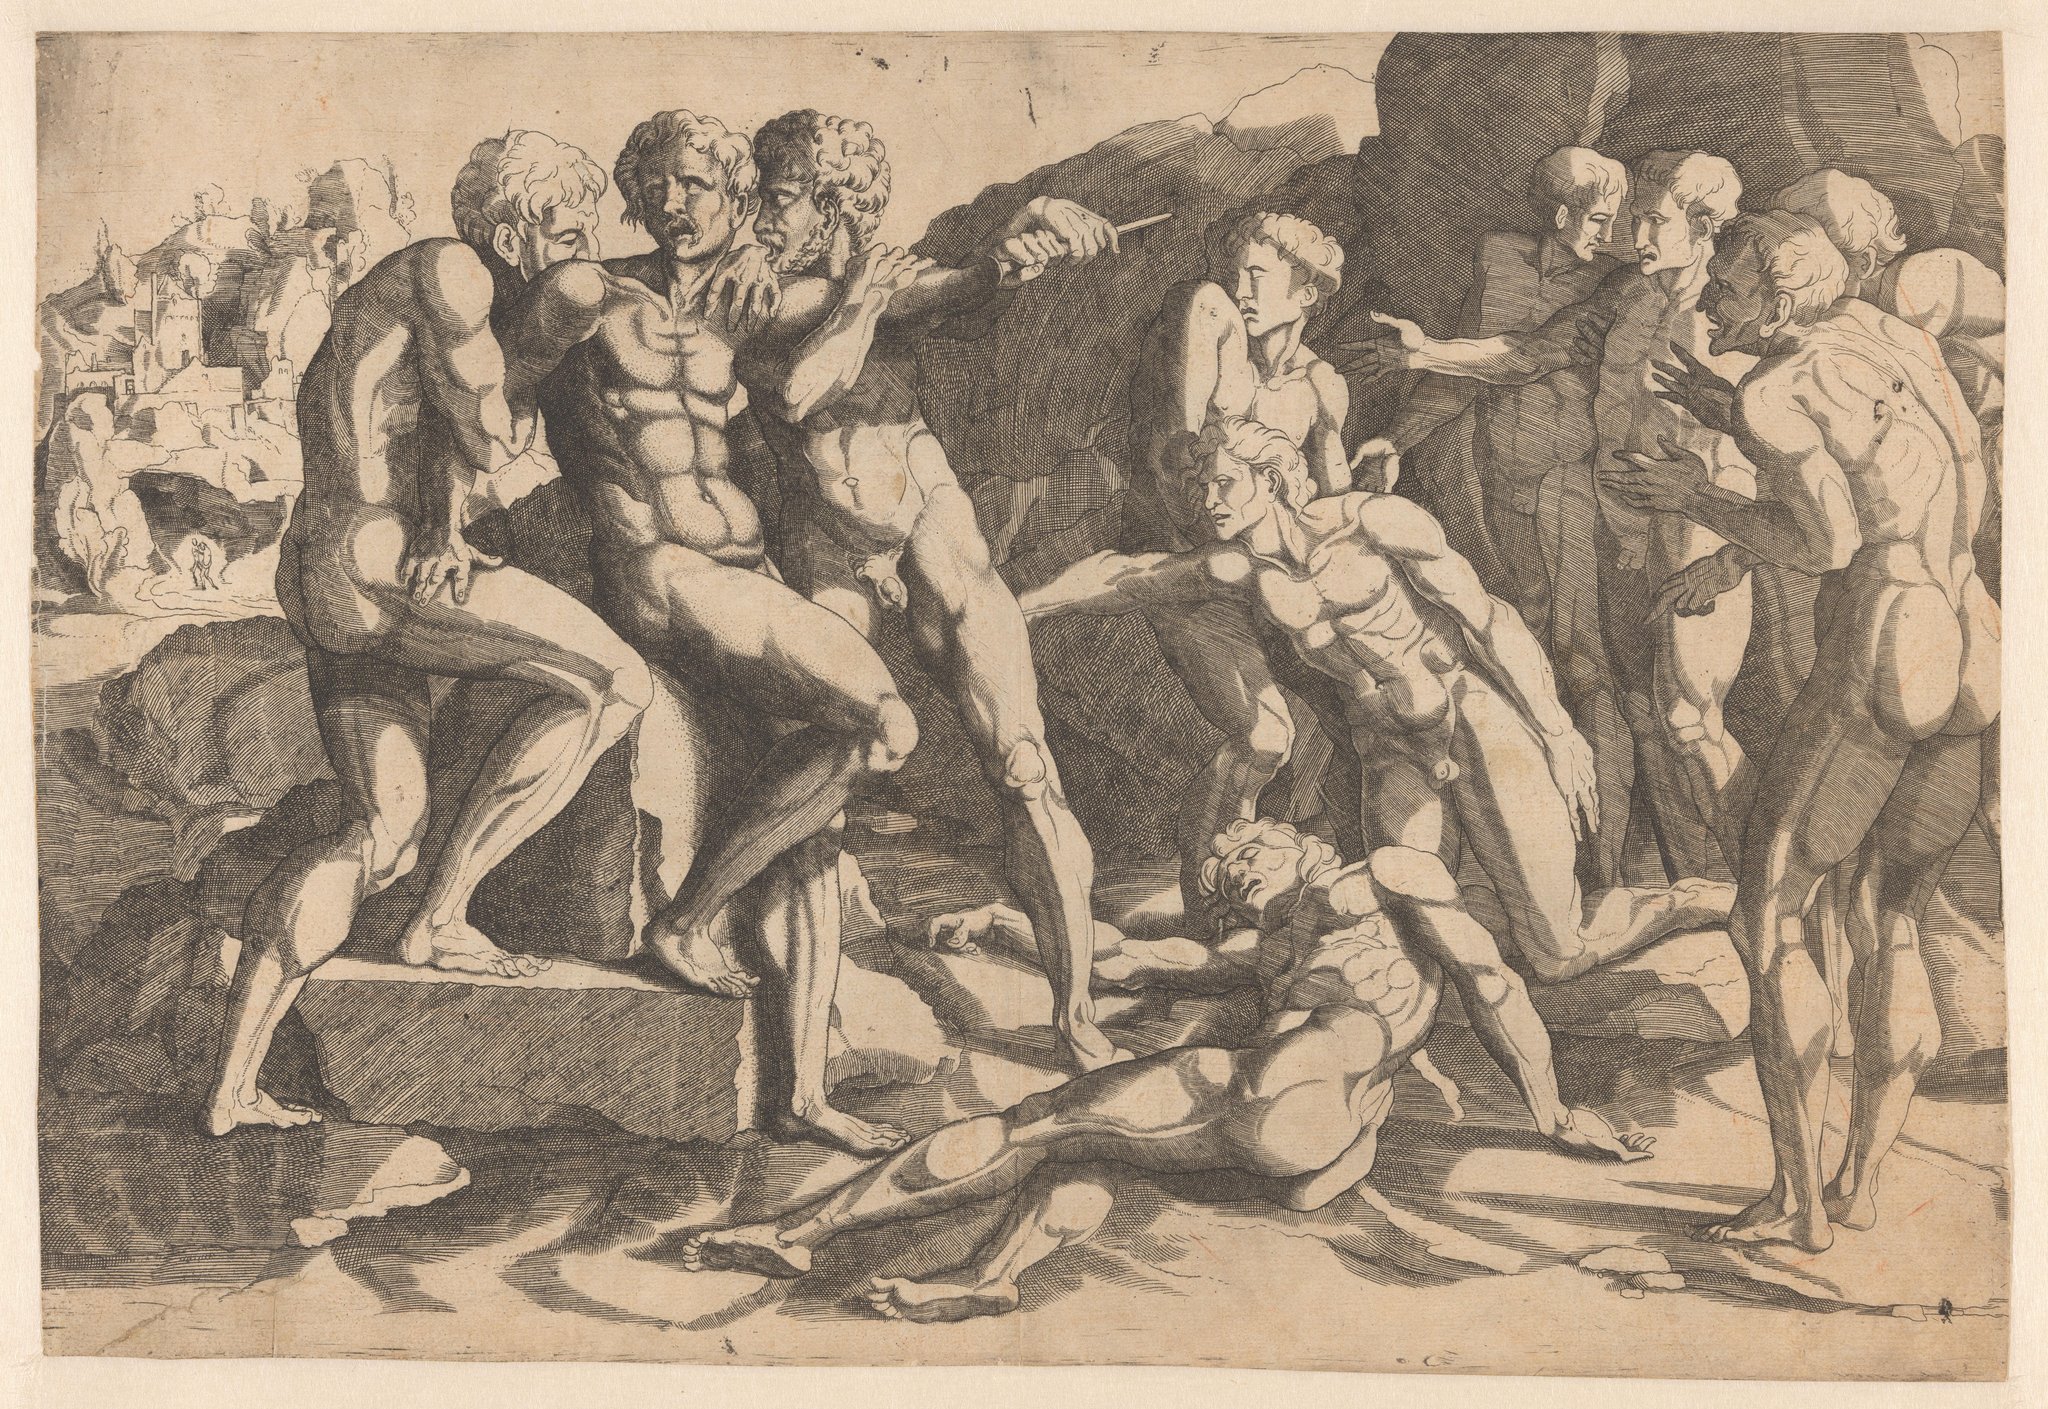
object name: print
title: Naakte mannen in gevecht bij een grot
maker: domenico del barbiere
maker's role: painter, print maker, sculptor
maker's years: 1506-1575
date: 1540-1550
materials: ink, paper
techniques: engraving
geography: troyes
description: Scène met tien naakte mannen voor een rotspartij in een landschap. Op de grond ligt een gewonde of dode man. Een man met een dolk in zijn hand wordt vastgehouden door twee anderen.